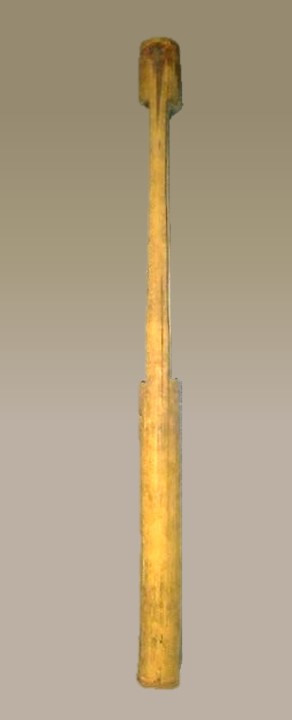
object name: walet hkok clapper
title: Walet-hkok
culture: burmese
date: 1867-1900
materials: bamboo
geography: myanmar